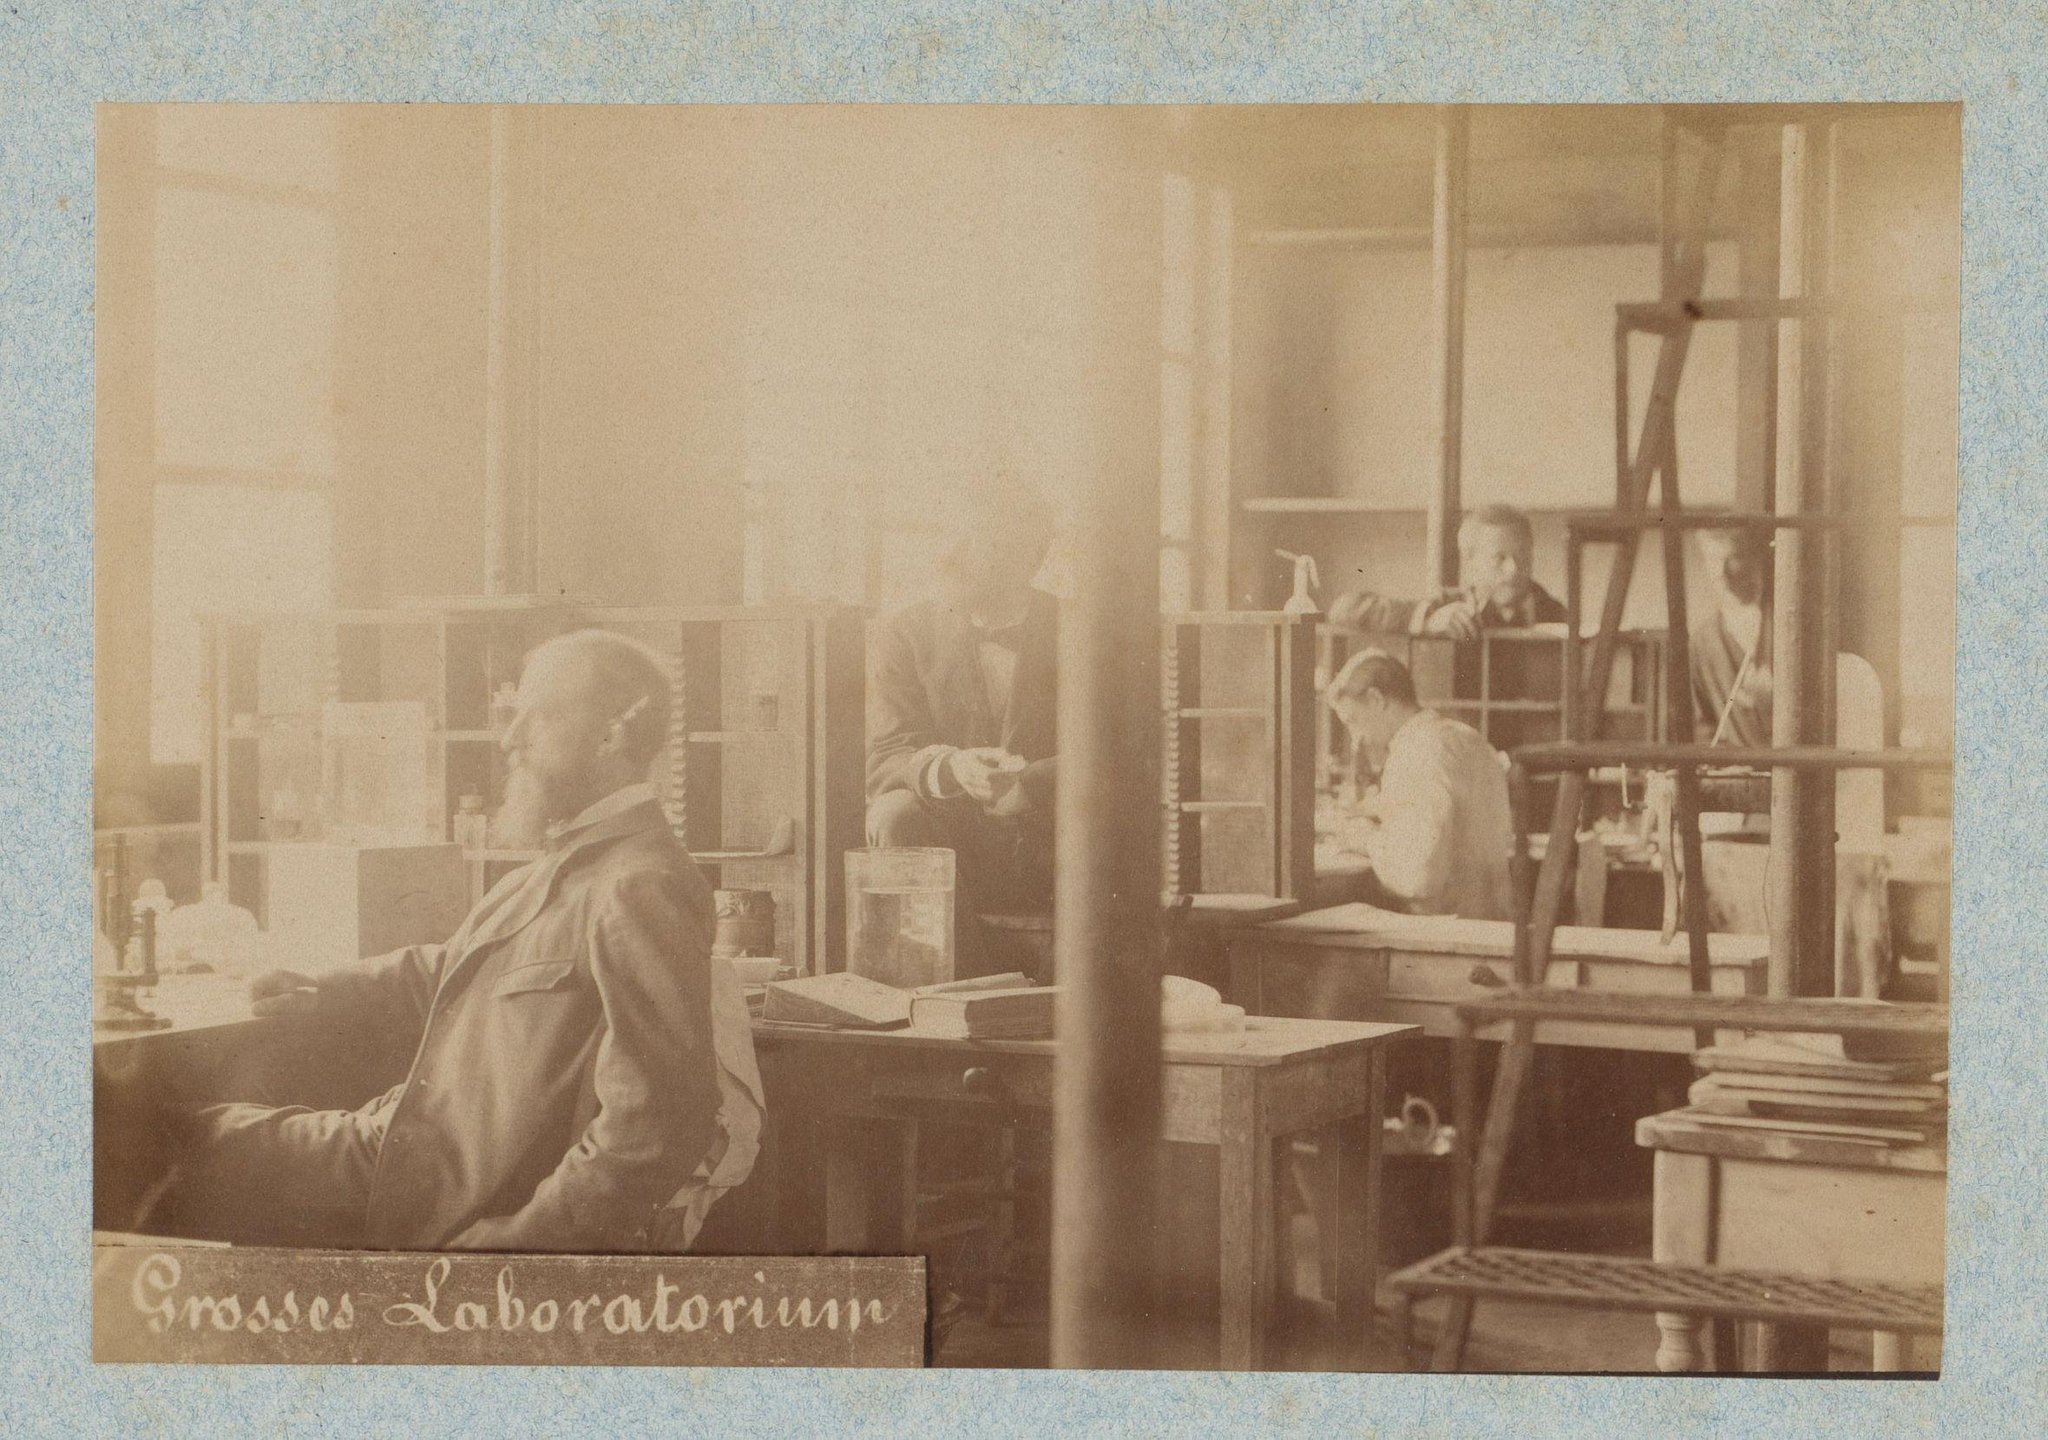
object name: photograph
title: Onderzoekers aan het werk in het Zoölogisch Station te Napels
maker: Anonymous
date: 1874-1900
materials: cardboard, paper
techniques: albumen print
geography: naples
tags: laboratory (+ tools, instruments; laboratory equipment ~ scientific research)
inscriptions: collector's mark: ‘VOSMAER’